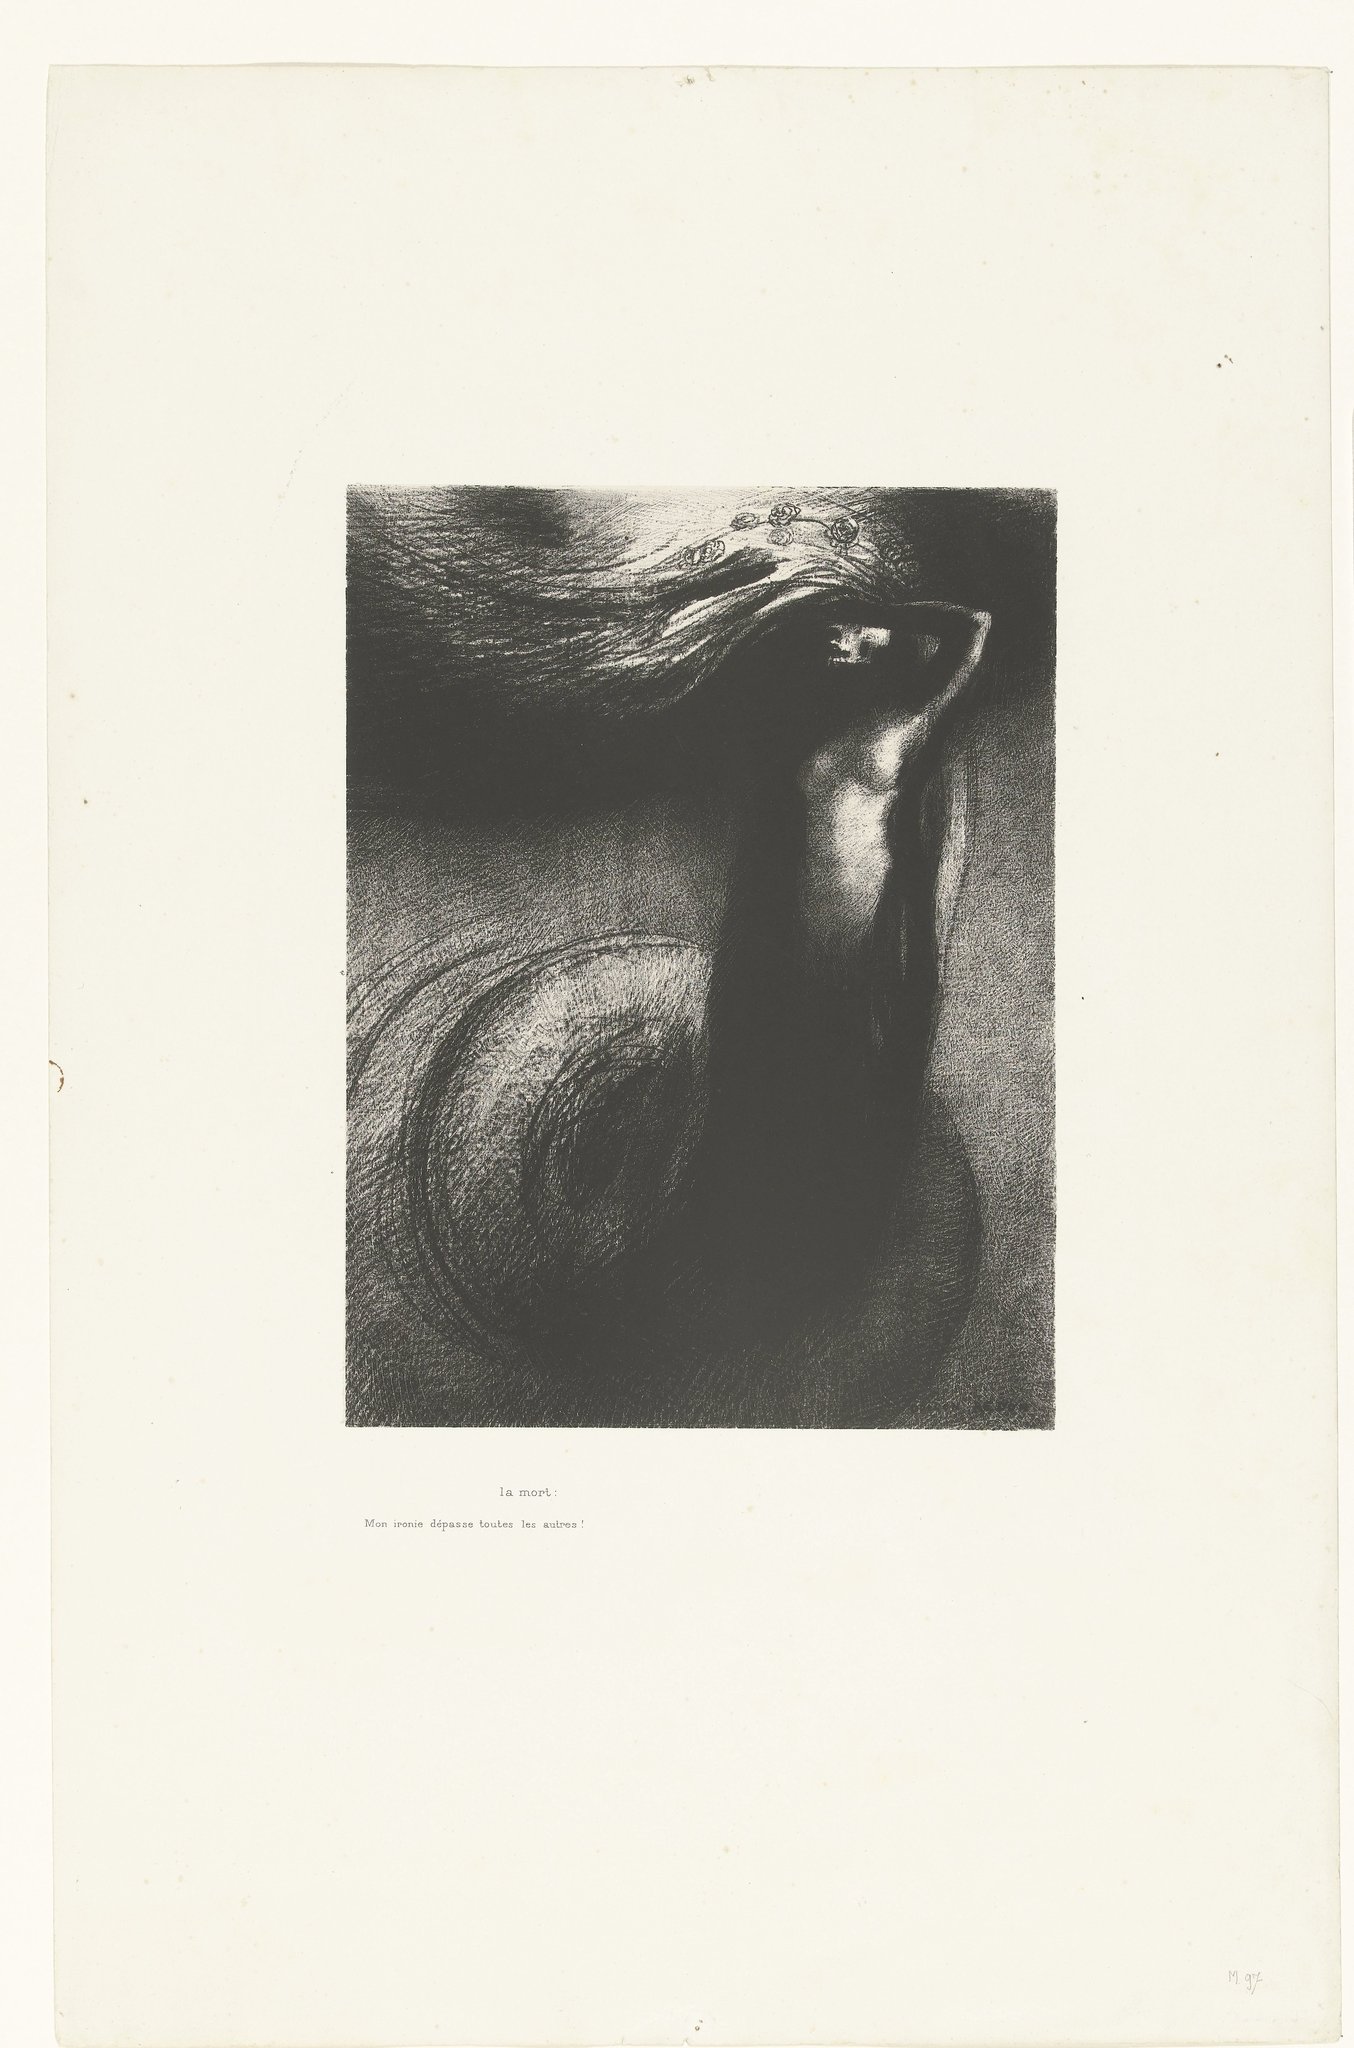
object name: print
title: De Dood: mijn ironie steekt boven alle andere uit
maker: odilon redon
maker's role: draughtsman, painter, print maker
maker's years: 1840-1916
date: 1889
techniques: printmaking, lithograph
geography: paris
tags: monsters of mixed human and animal shape; 'mostri' (ripa), personifications of death; 'morte' (ripa), temptations of st. antony abbot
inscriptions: collector's mark: Lugt 2228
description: Een naakte vrouw met een slangenstaart. In haar naar voren wapperende haren enkele bloemen. Derde prent van zes uit de tweede serie illustraties voor Gustave Flauberts De verzoeking van de heilige Antonius.